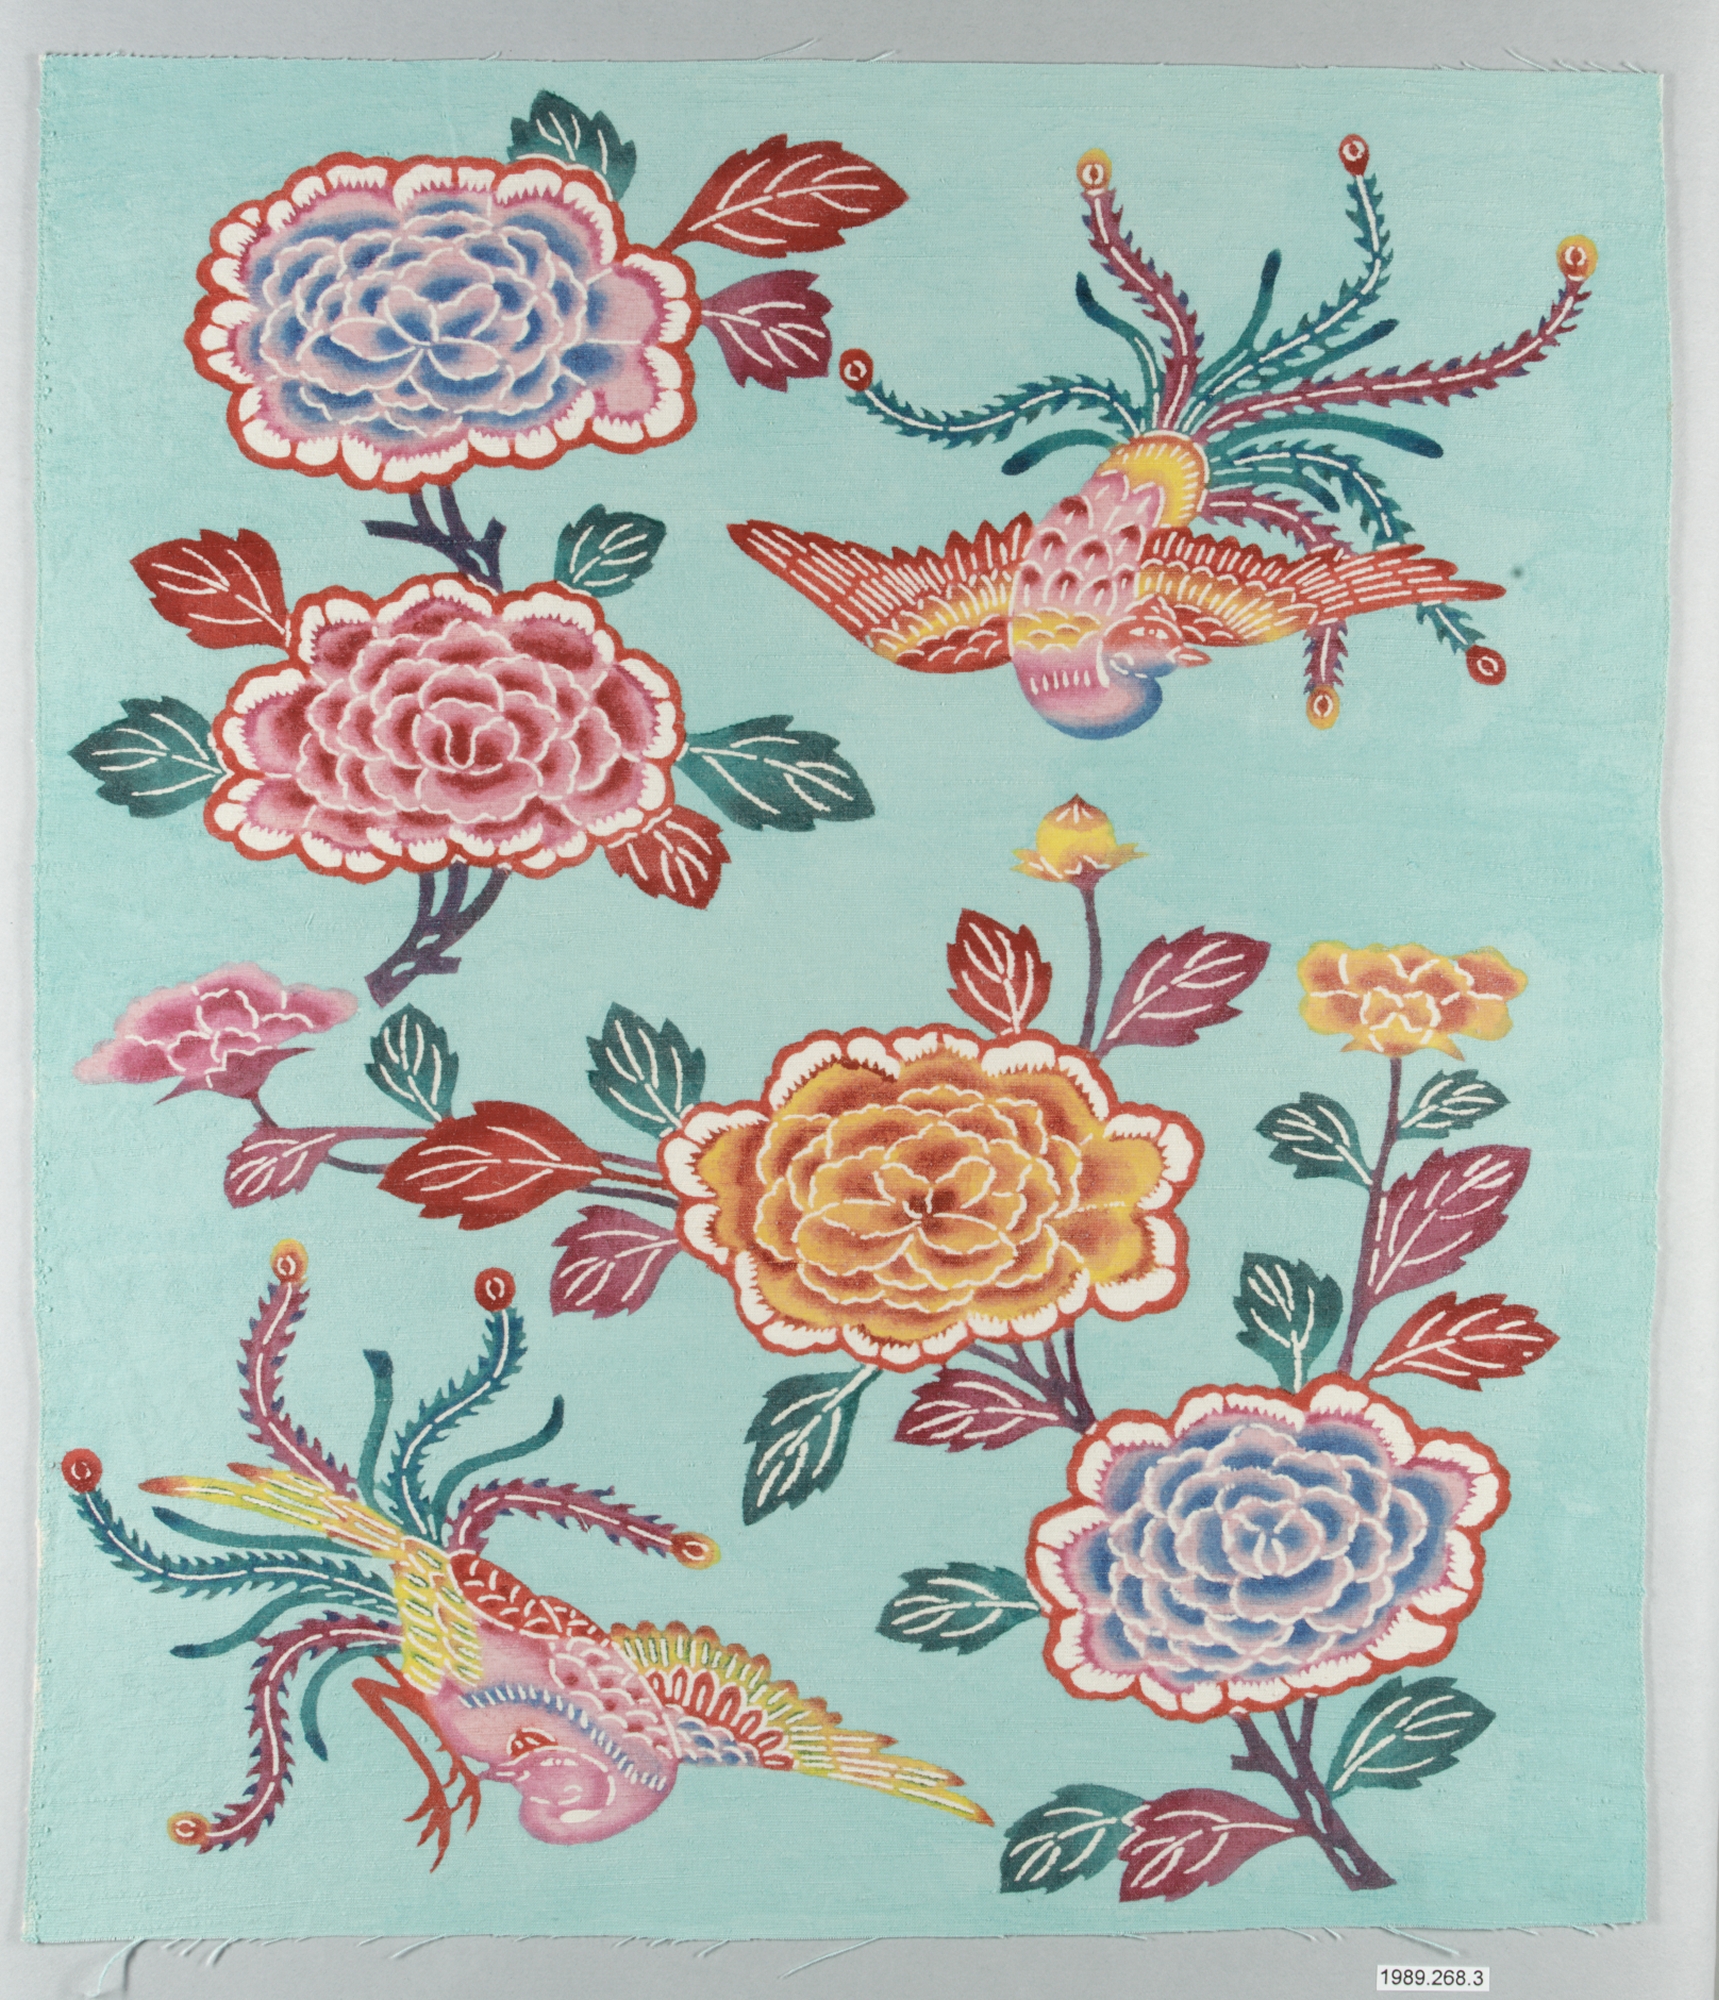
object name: bingata panel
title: Bingata Panel with Tree Peonies and Peacocks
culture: japanese or ryukyuan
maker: teruyo shinohara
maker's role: artist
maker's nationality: japanese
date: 1901-2000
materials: cotton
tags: peacocks,peonies